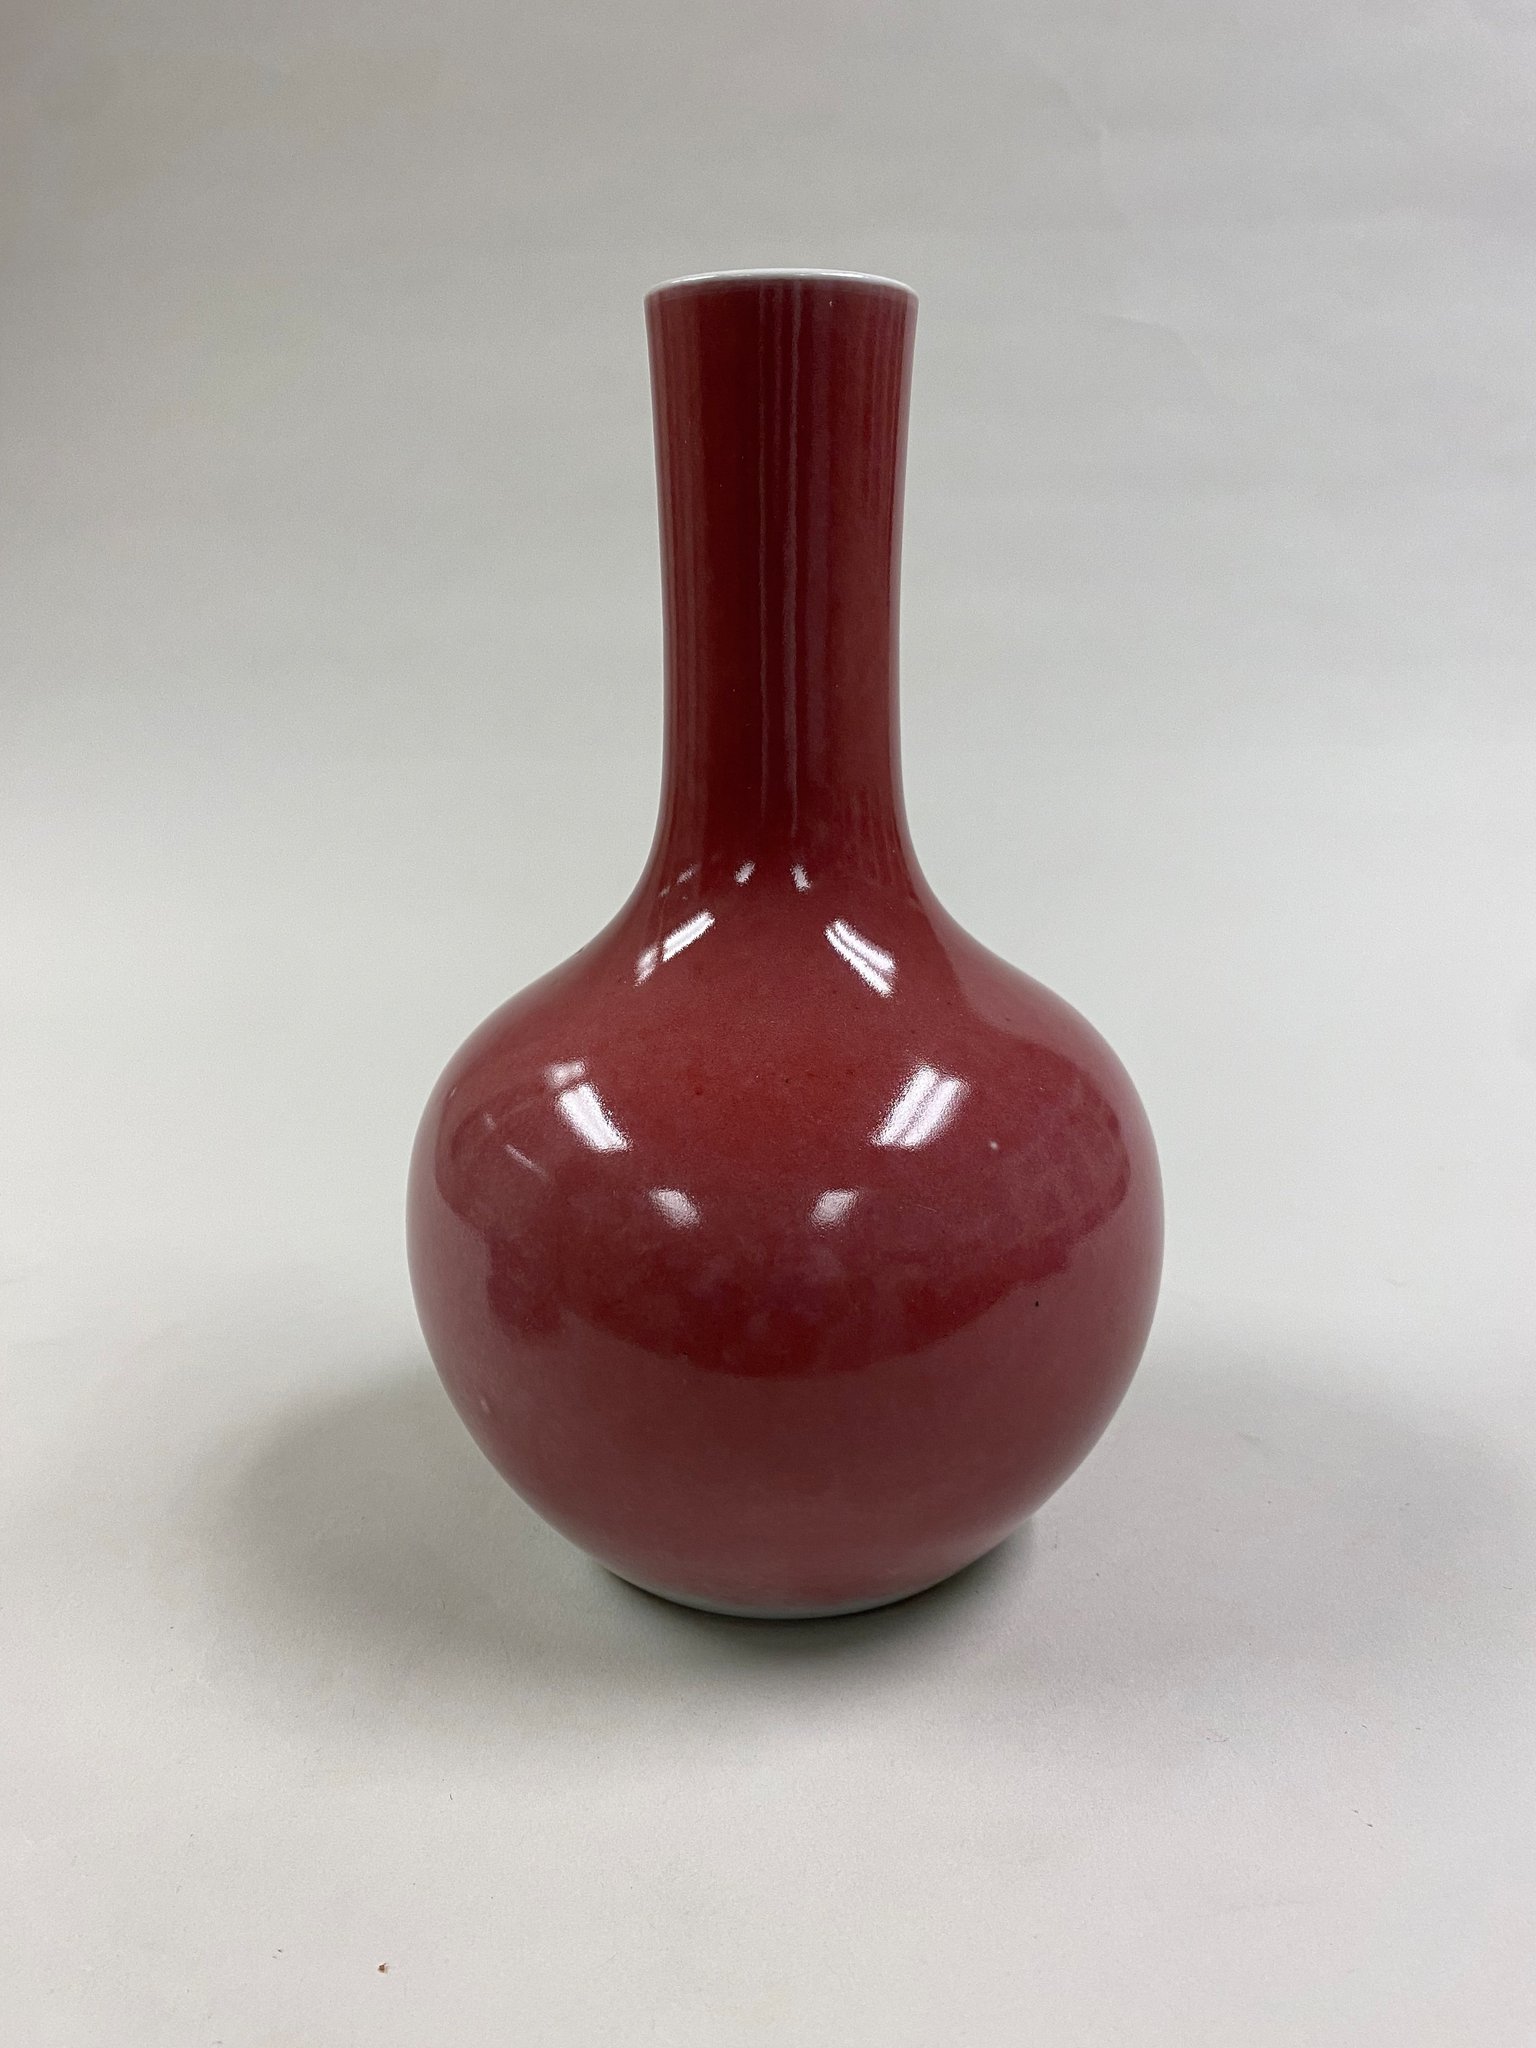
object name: vase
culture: chinese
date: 1701-1733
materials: copper, glaze, porcelain